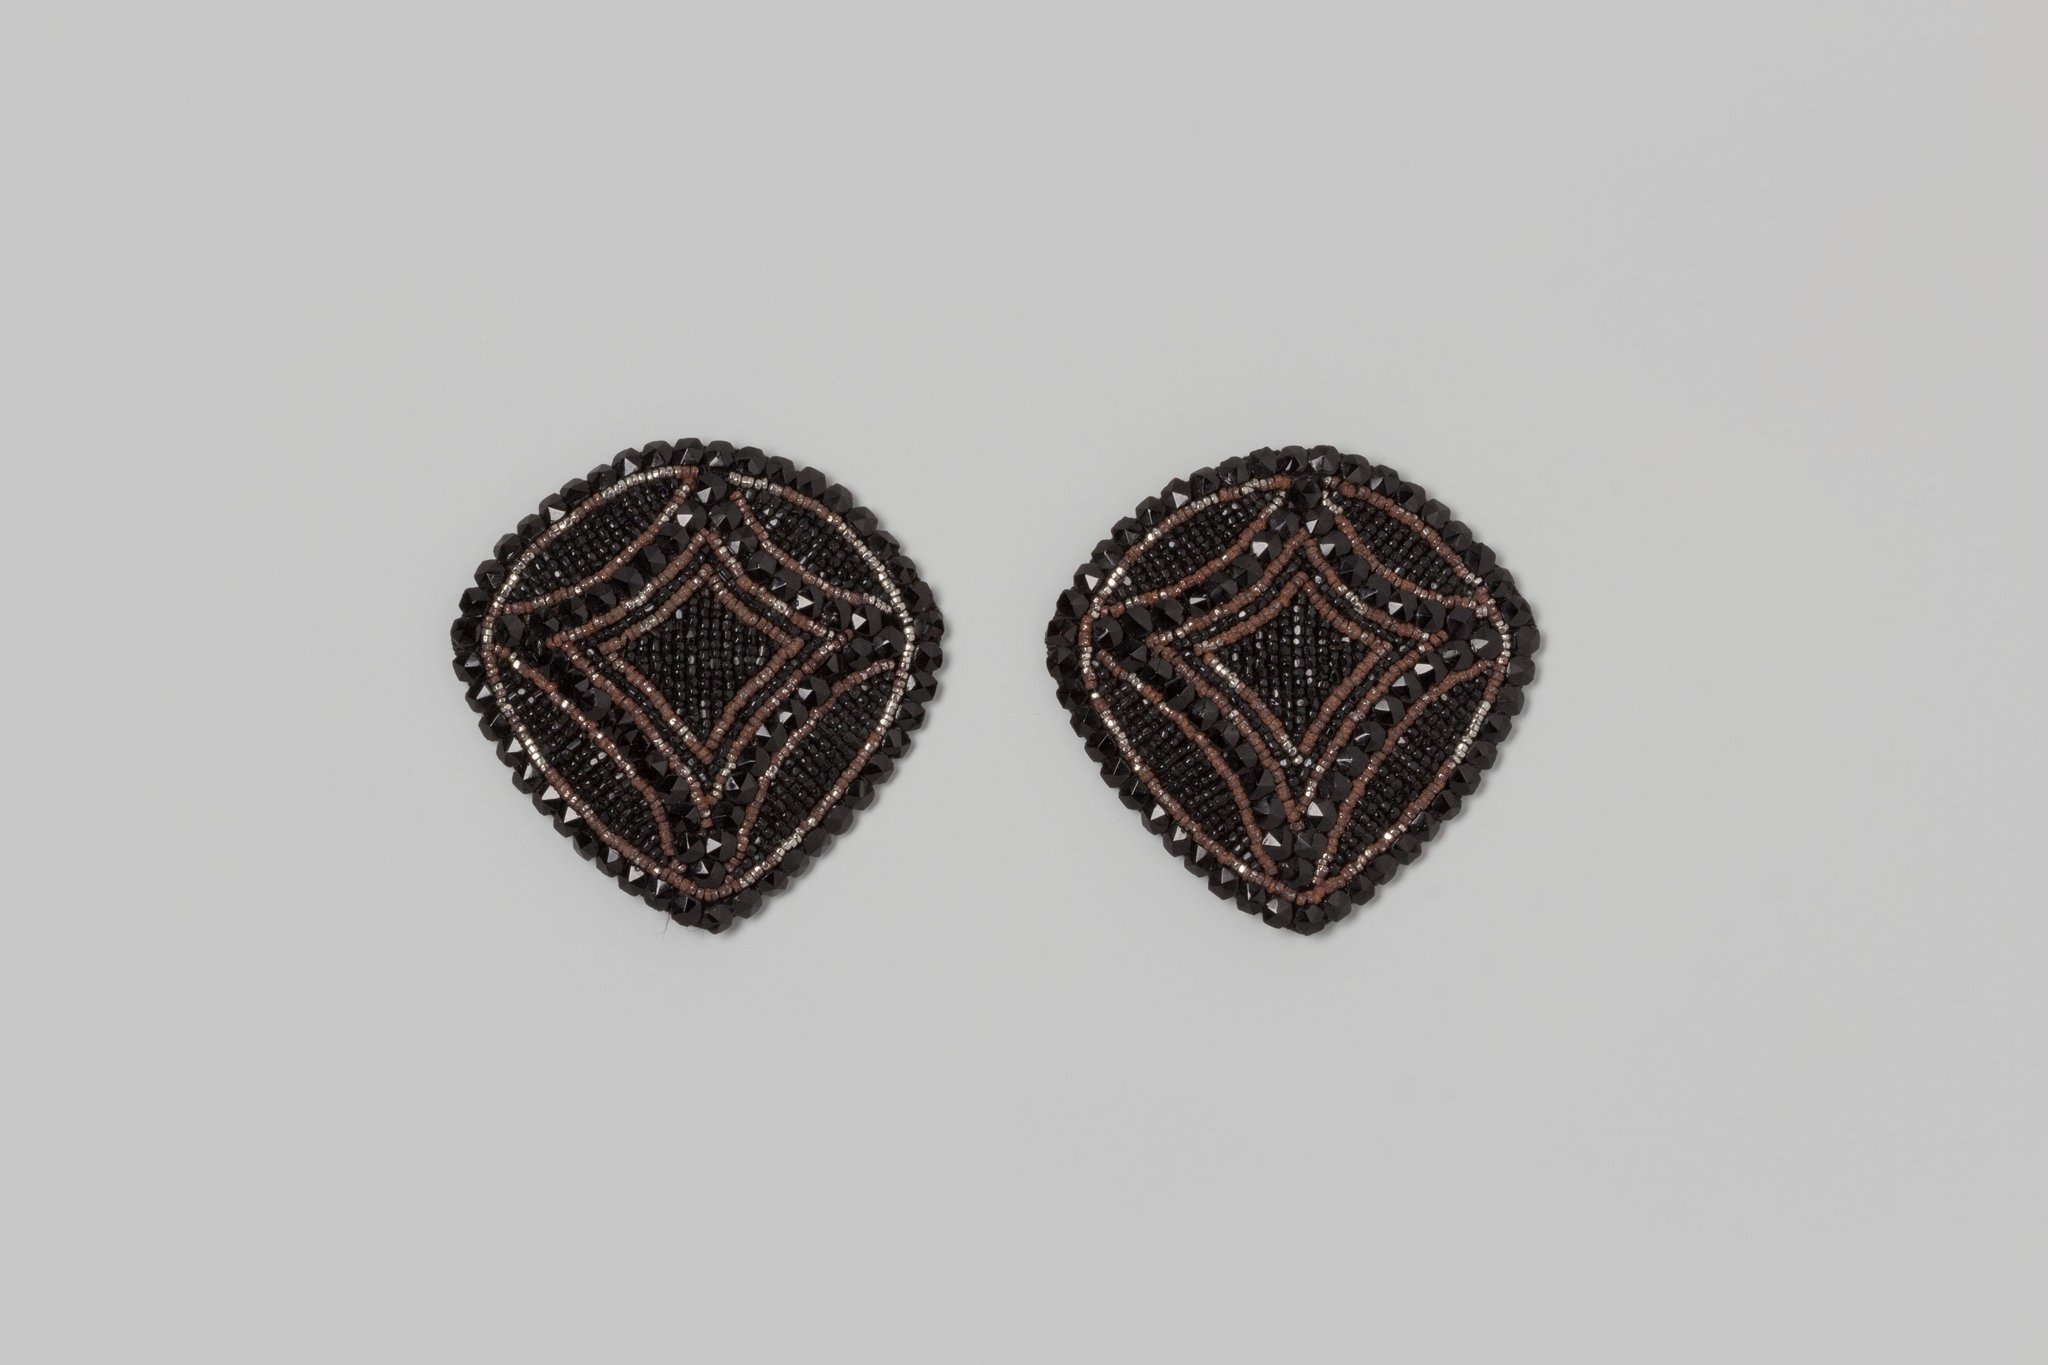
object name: clothing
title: Gesp, druppelvormig, van een met gitten en kralen geborduurde ondergrond van textiel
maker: Anonymous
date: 1900-1925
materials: glass, jet, textile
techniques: embroidered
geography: western europe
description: Druppelvormige gesp van een met gitten en kralen geborduurde ondergrond van textiel. Op de gesp is een versiering aangebracht van goudkleurige en zwarte kralen. De gesp is afgezet met een rij zwarte kralen.